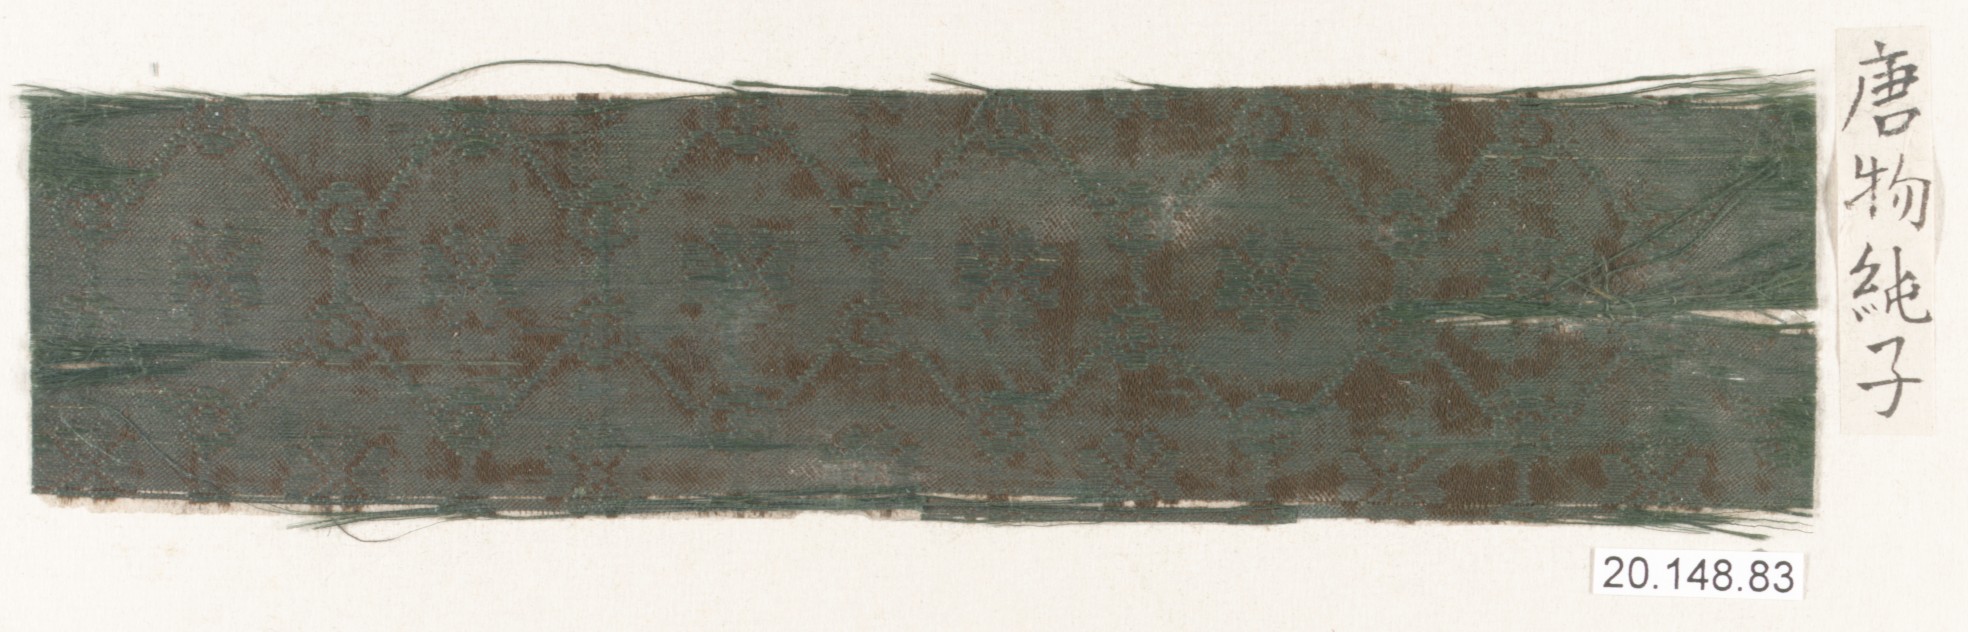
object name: piece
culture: chinese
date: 1601-1700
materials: silk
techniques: compound weave